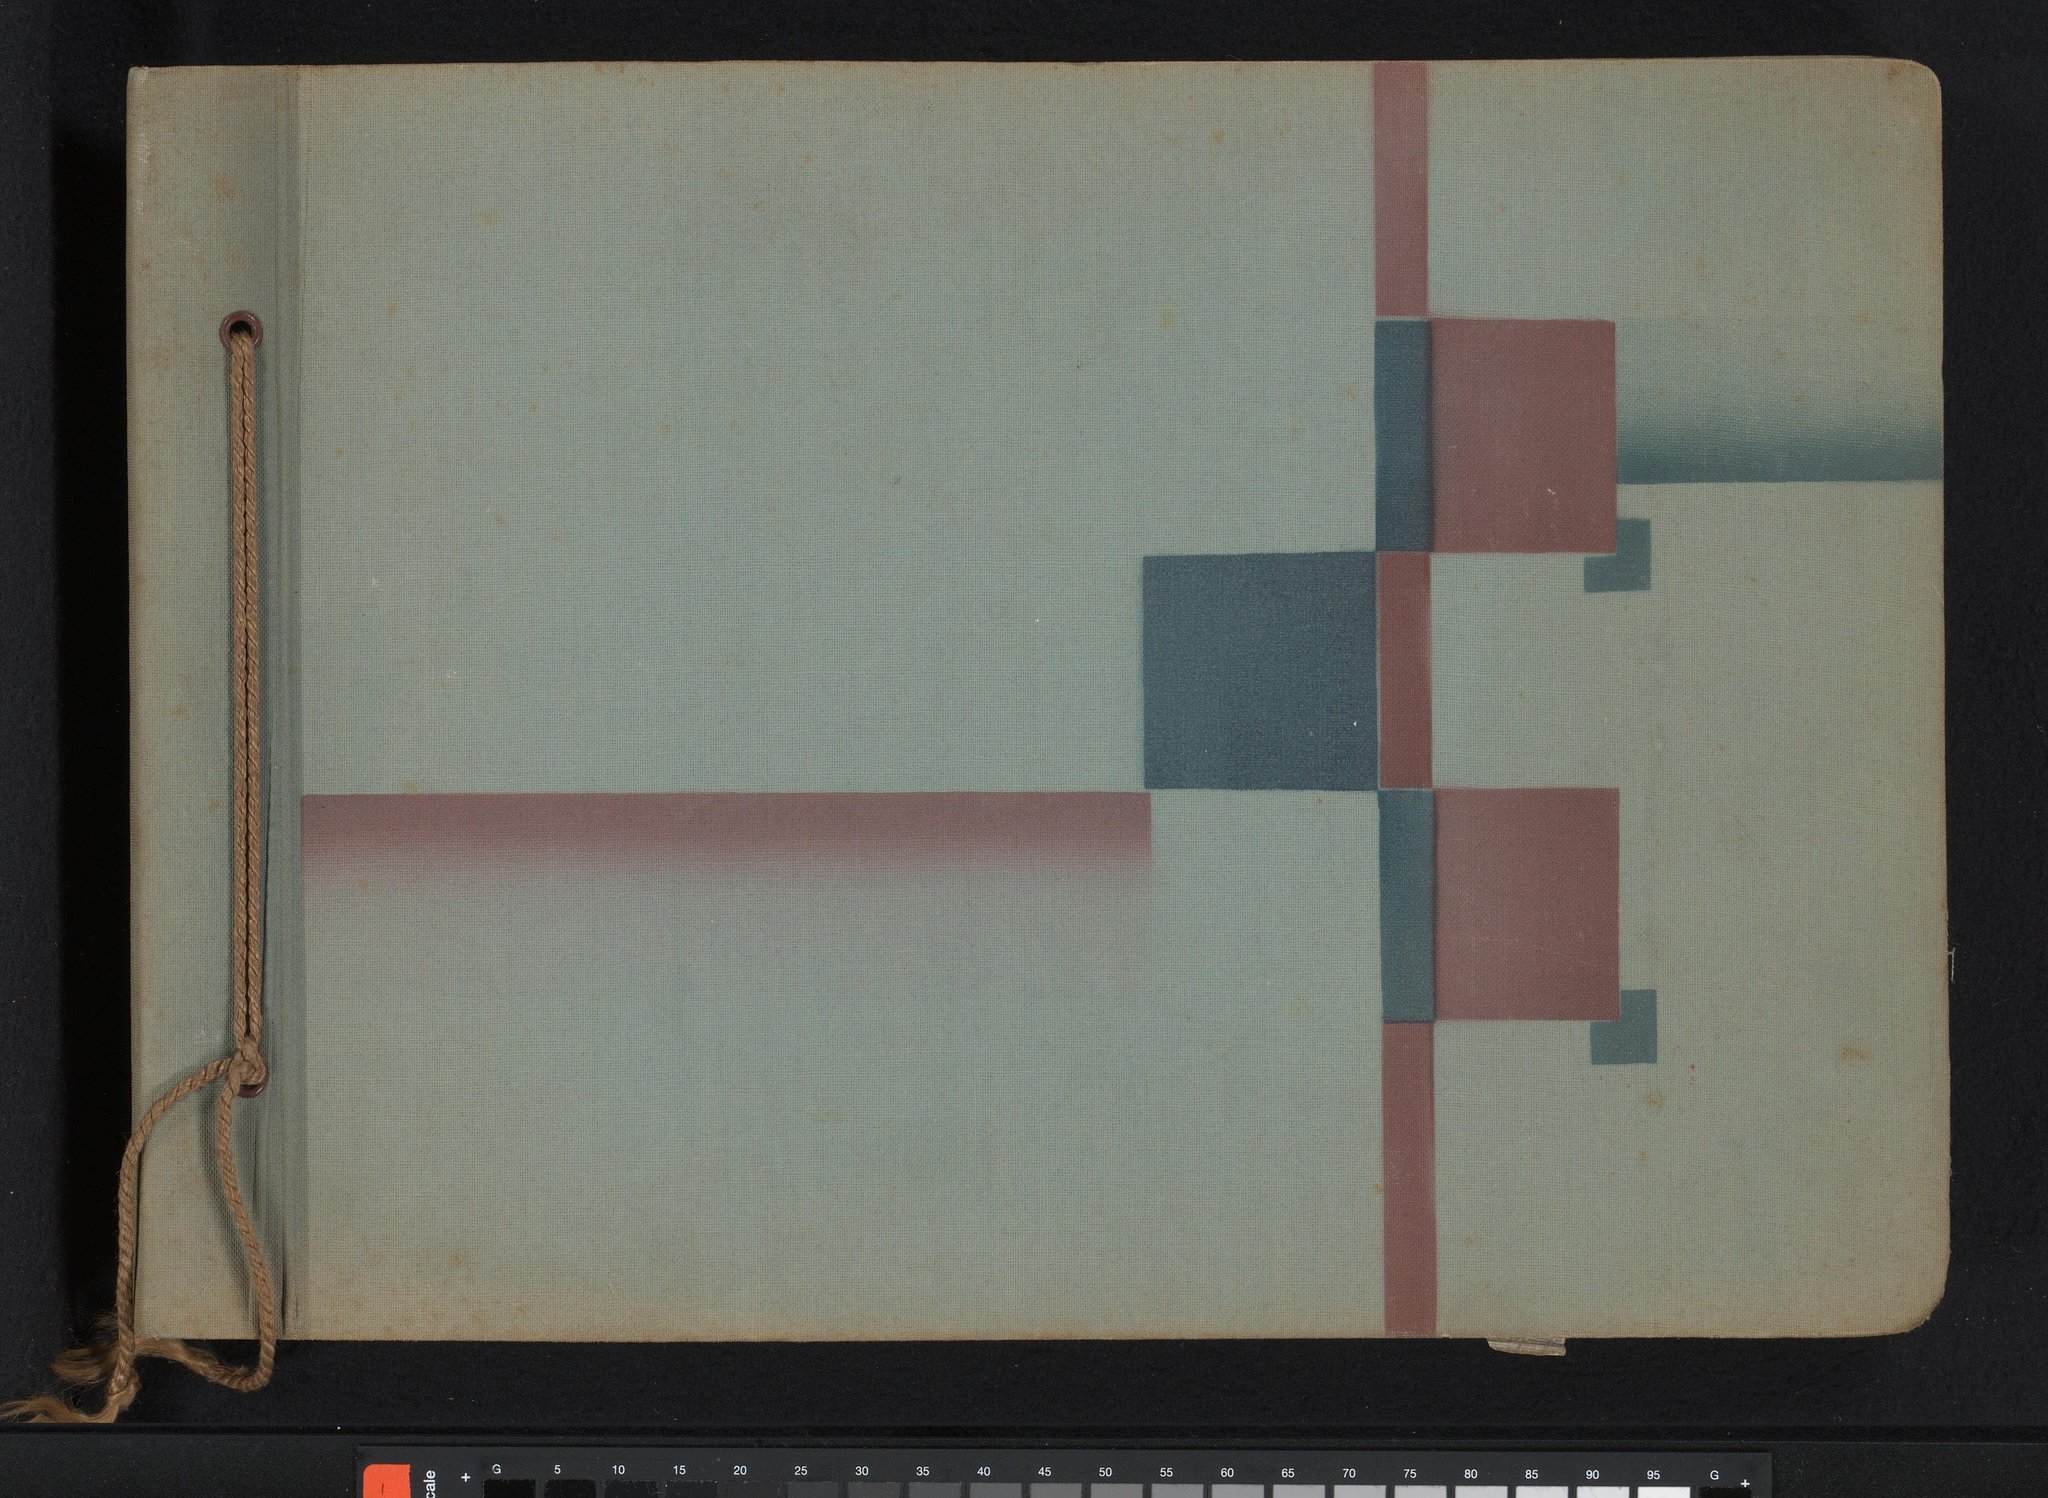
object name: slip in album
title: Fotoalbum van een jonge vrouw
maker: Anonymous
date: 1935-1945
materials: cardboard, linen, paper, photographic support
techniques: gelatin silver print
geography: netherlands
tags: amsterdam, cologne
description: Fotoalbum met een groenige, Art Deco-stijl linnen omslag. Het album bevat 18 bladen van bruin karton met spinrag tussen. Het album bevat in totaal 143 foto's en lijkt samengesteld door een jonge vrouw die regelmatig te zien is op de foto's van allerlei uitstapjes met vrienden en familie, zeilen met een zeilschip en vakanties naar het buitenland. Mogelijk was de samensteller lid van de A.S.V. (Algemene Senaten Vergadering / Amsterdamse studentenvereniging?).